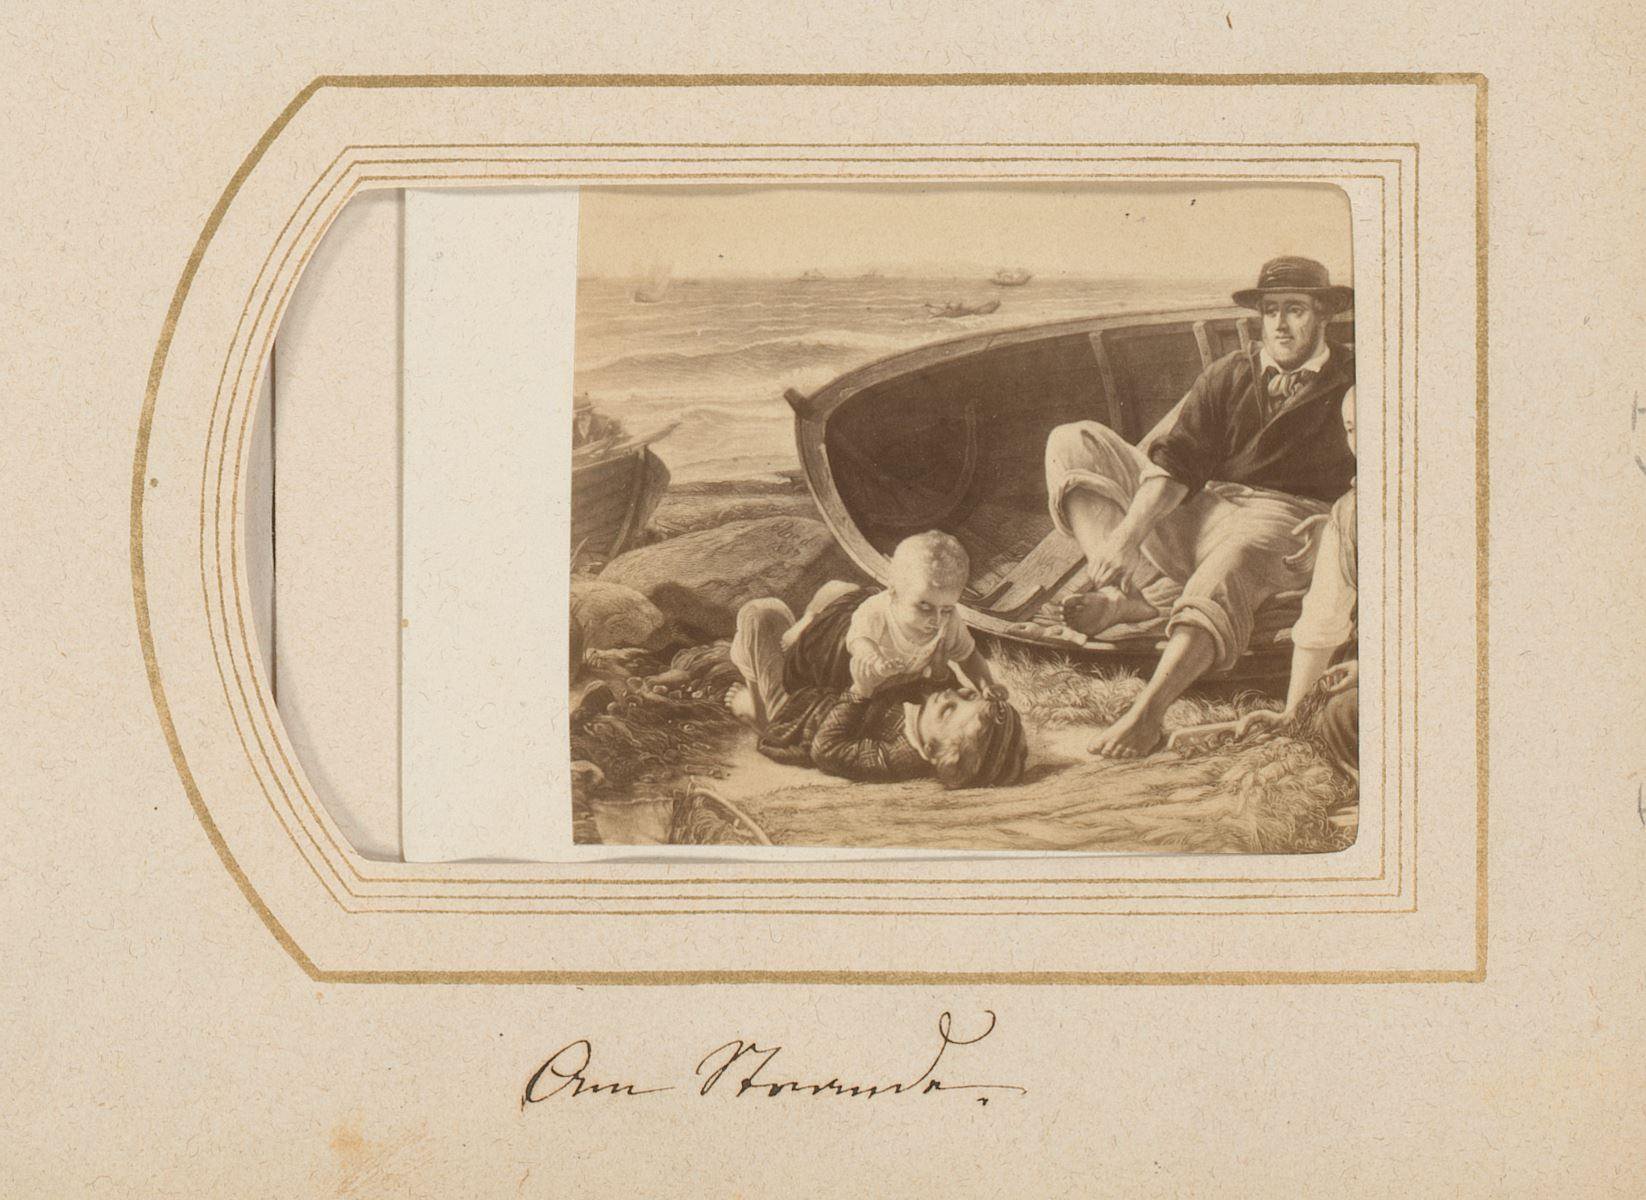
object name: album leaf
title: Fotoreproductie van Am Strande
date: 1870-1890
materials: cardboard, photographic support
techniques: albumen print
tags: adult man, child, rowing-boat, canoe, etc., painting, drawing and the graphic arts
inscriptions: number: ‘.2901’, annotation: ‘[...]’